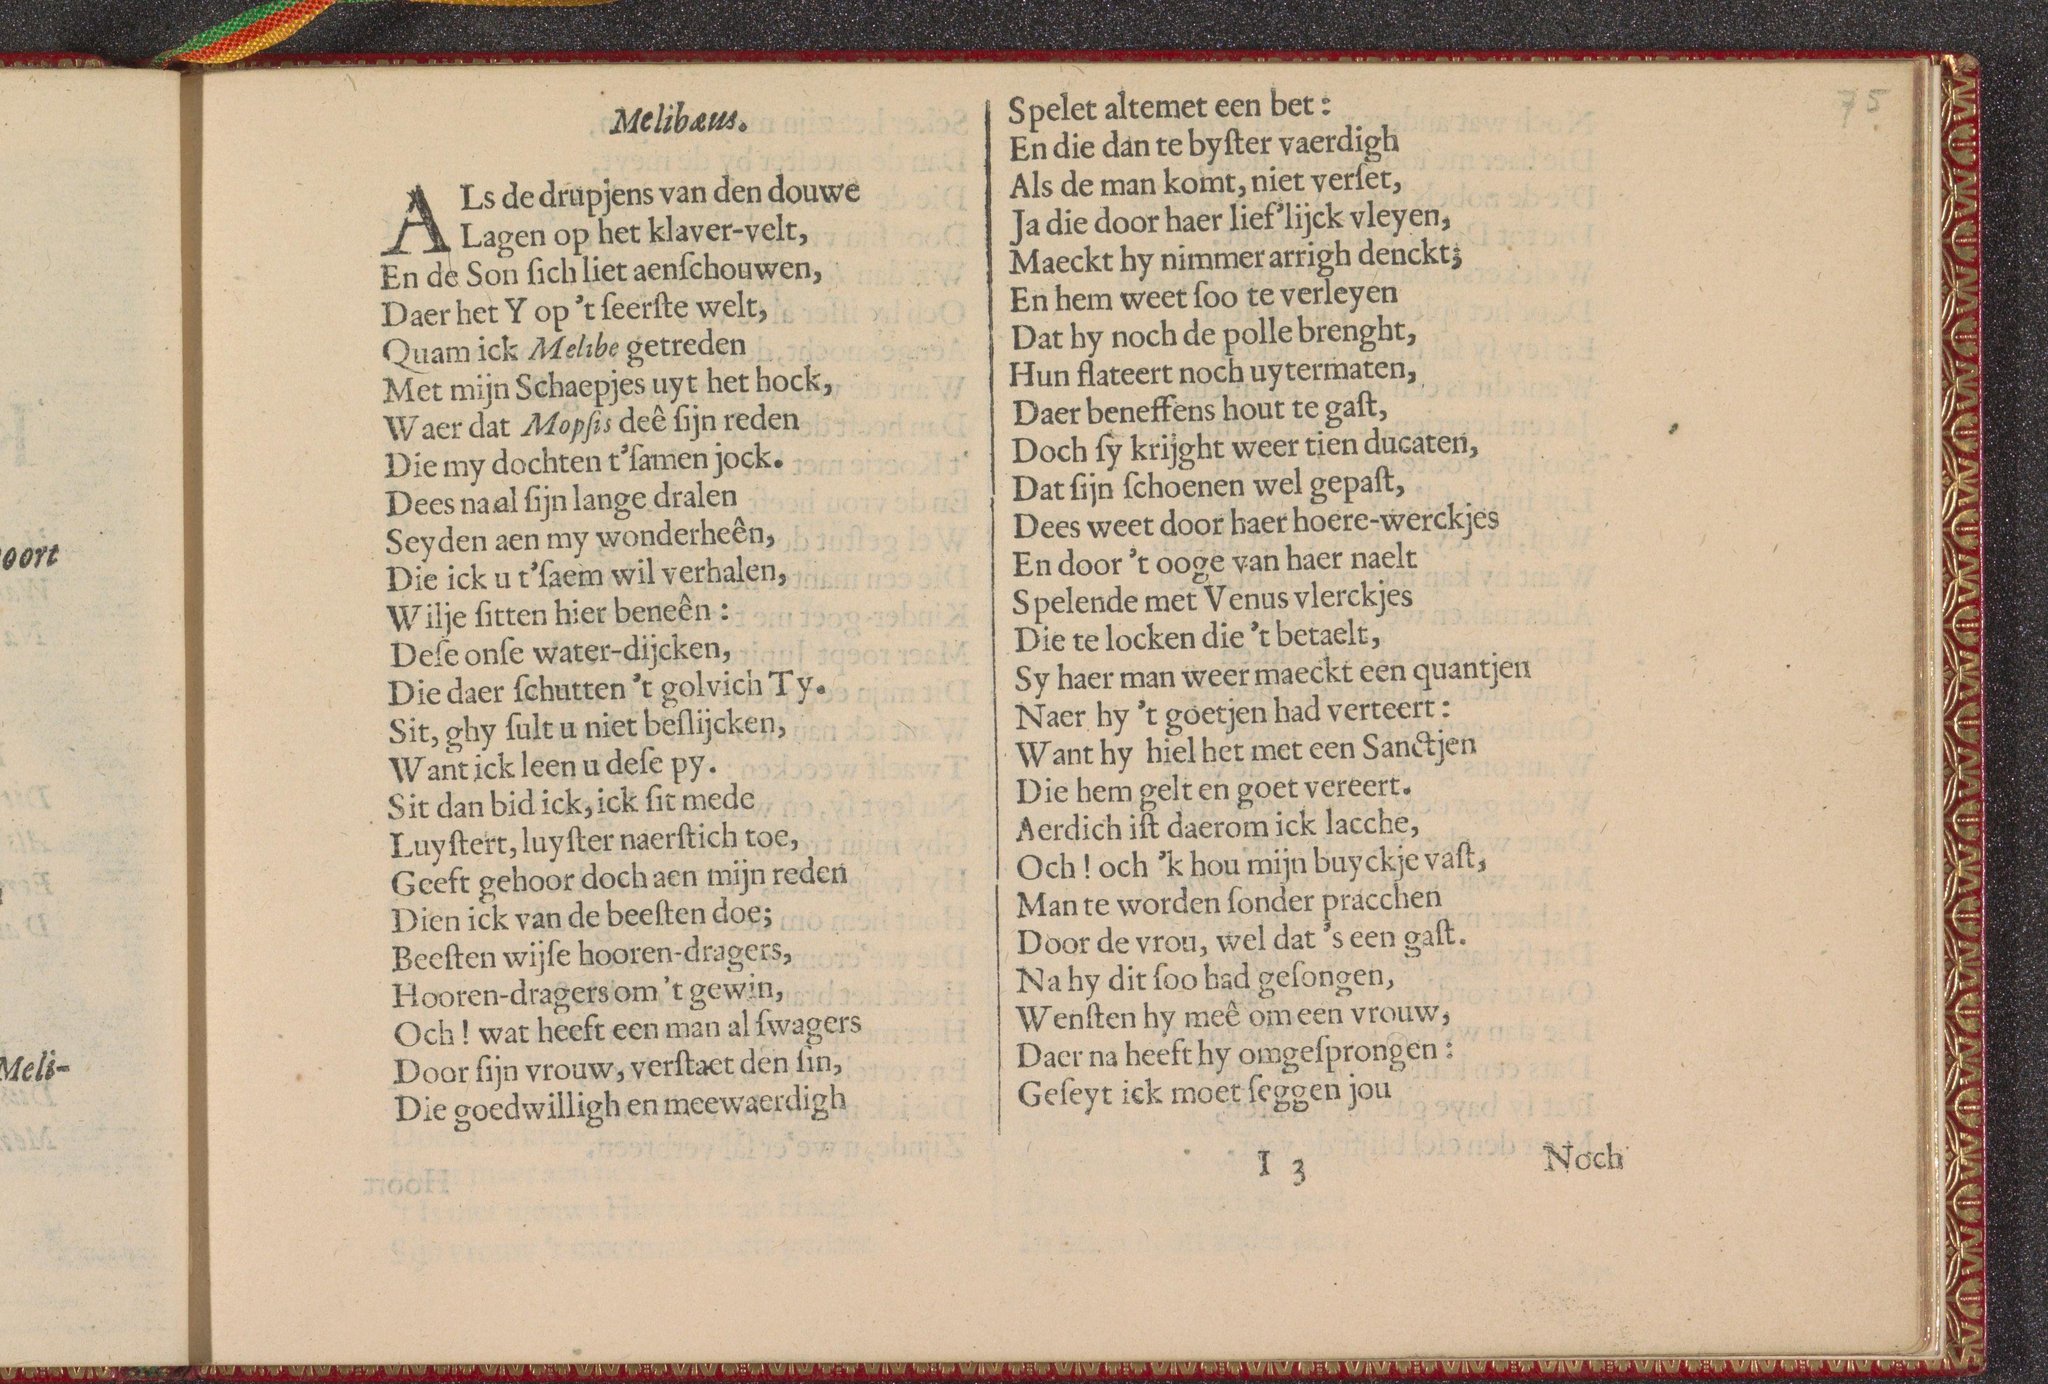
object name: text sheet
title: Vertelling van de herder Melibaeus, pagina 1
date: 1641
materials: paper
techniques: letterpress printing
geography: amsterdam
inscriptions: date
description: Vertelling van de herder Malibeaus op vier pagina's: pagina 1. Het blad maakt deel uit van een album.